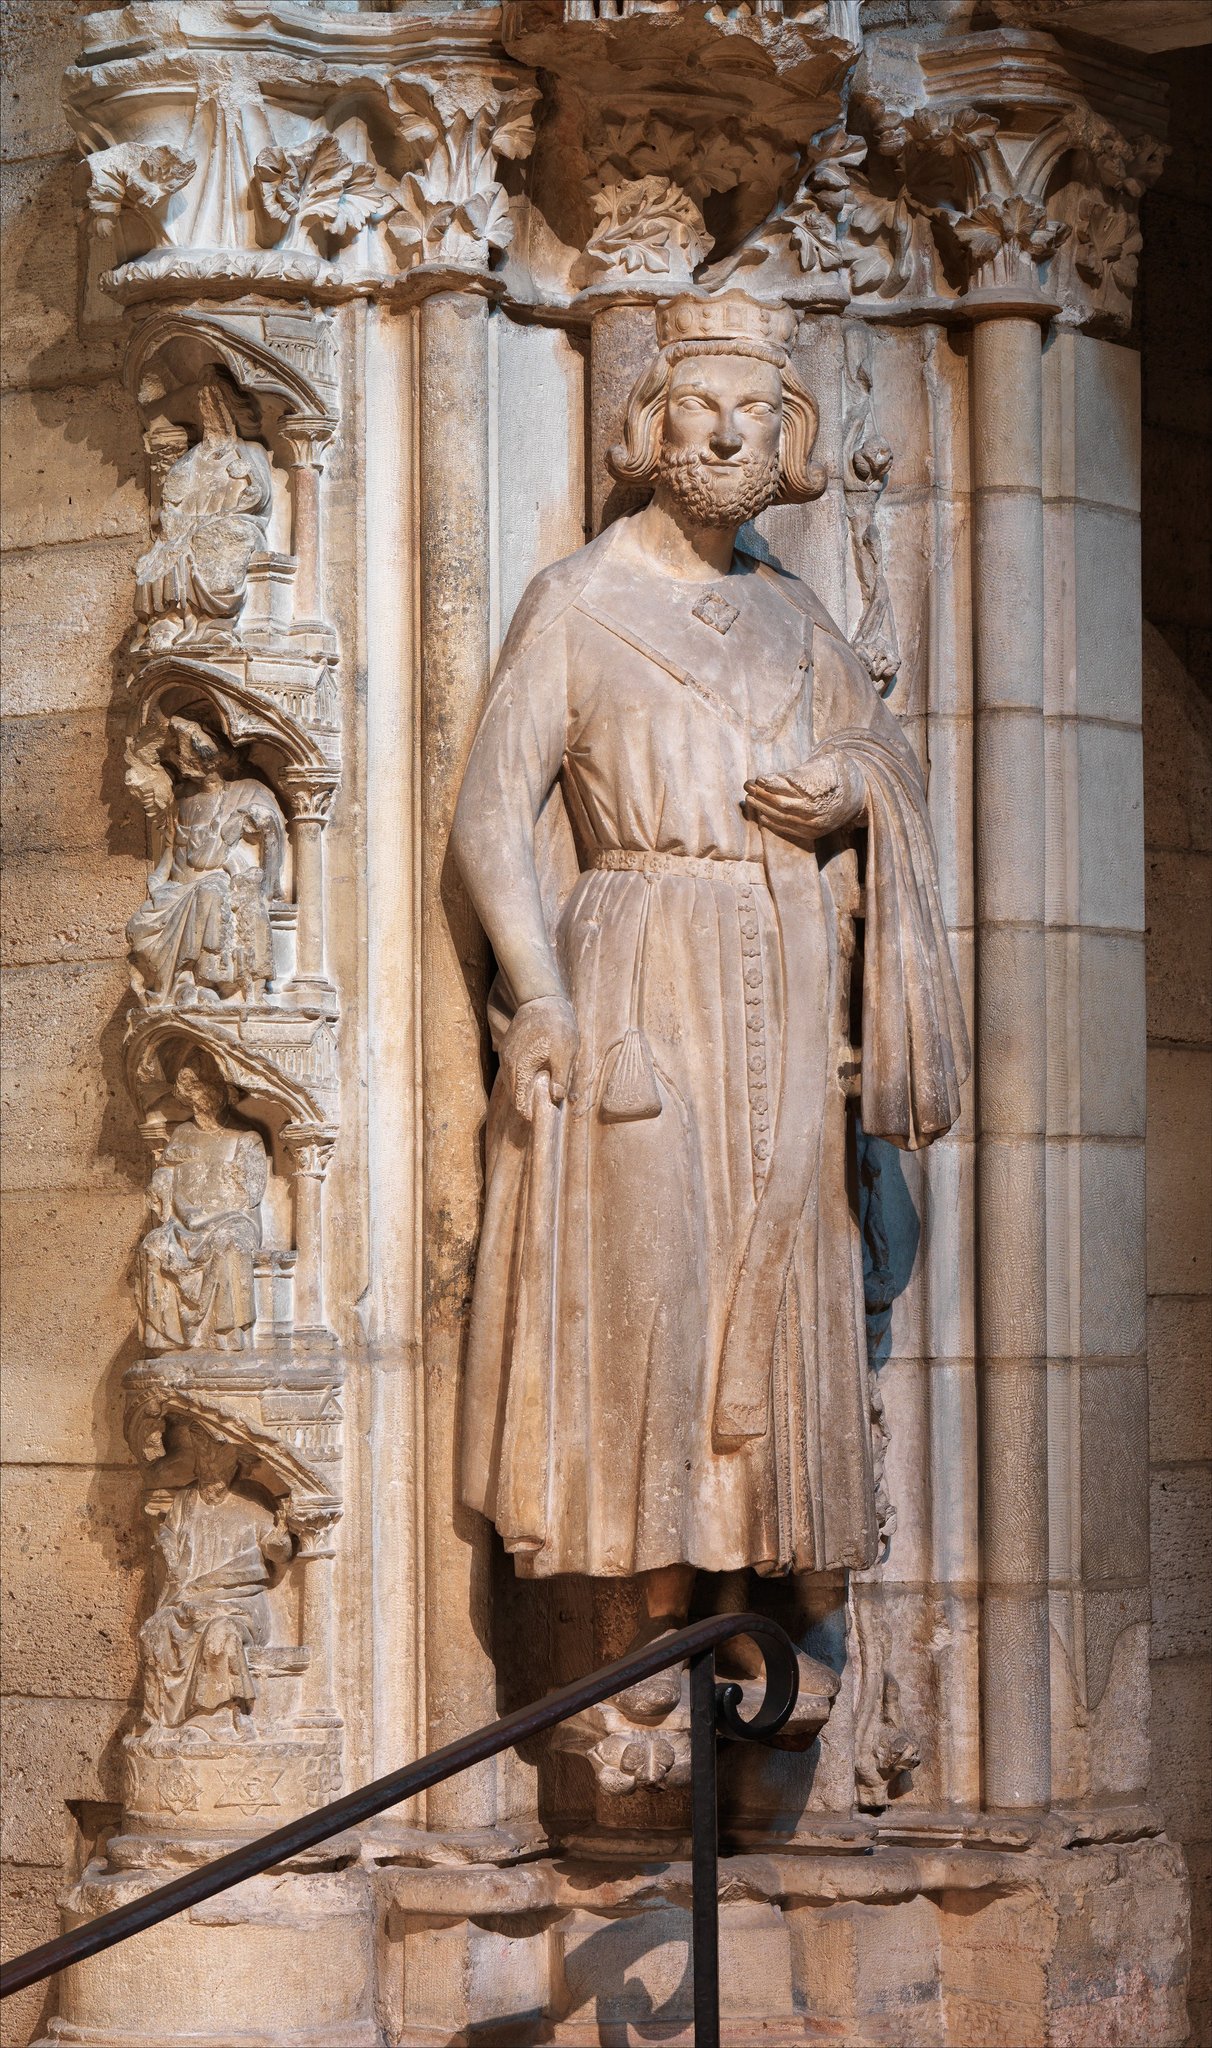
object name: statue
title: King Clovis I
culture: french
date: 1250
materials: limestone, paint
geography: france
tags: doorways,kings,men